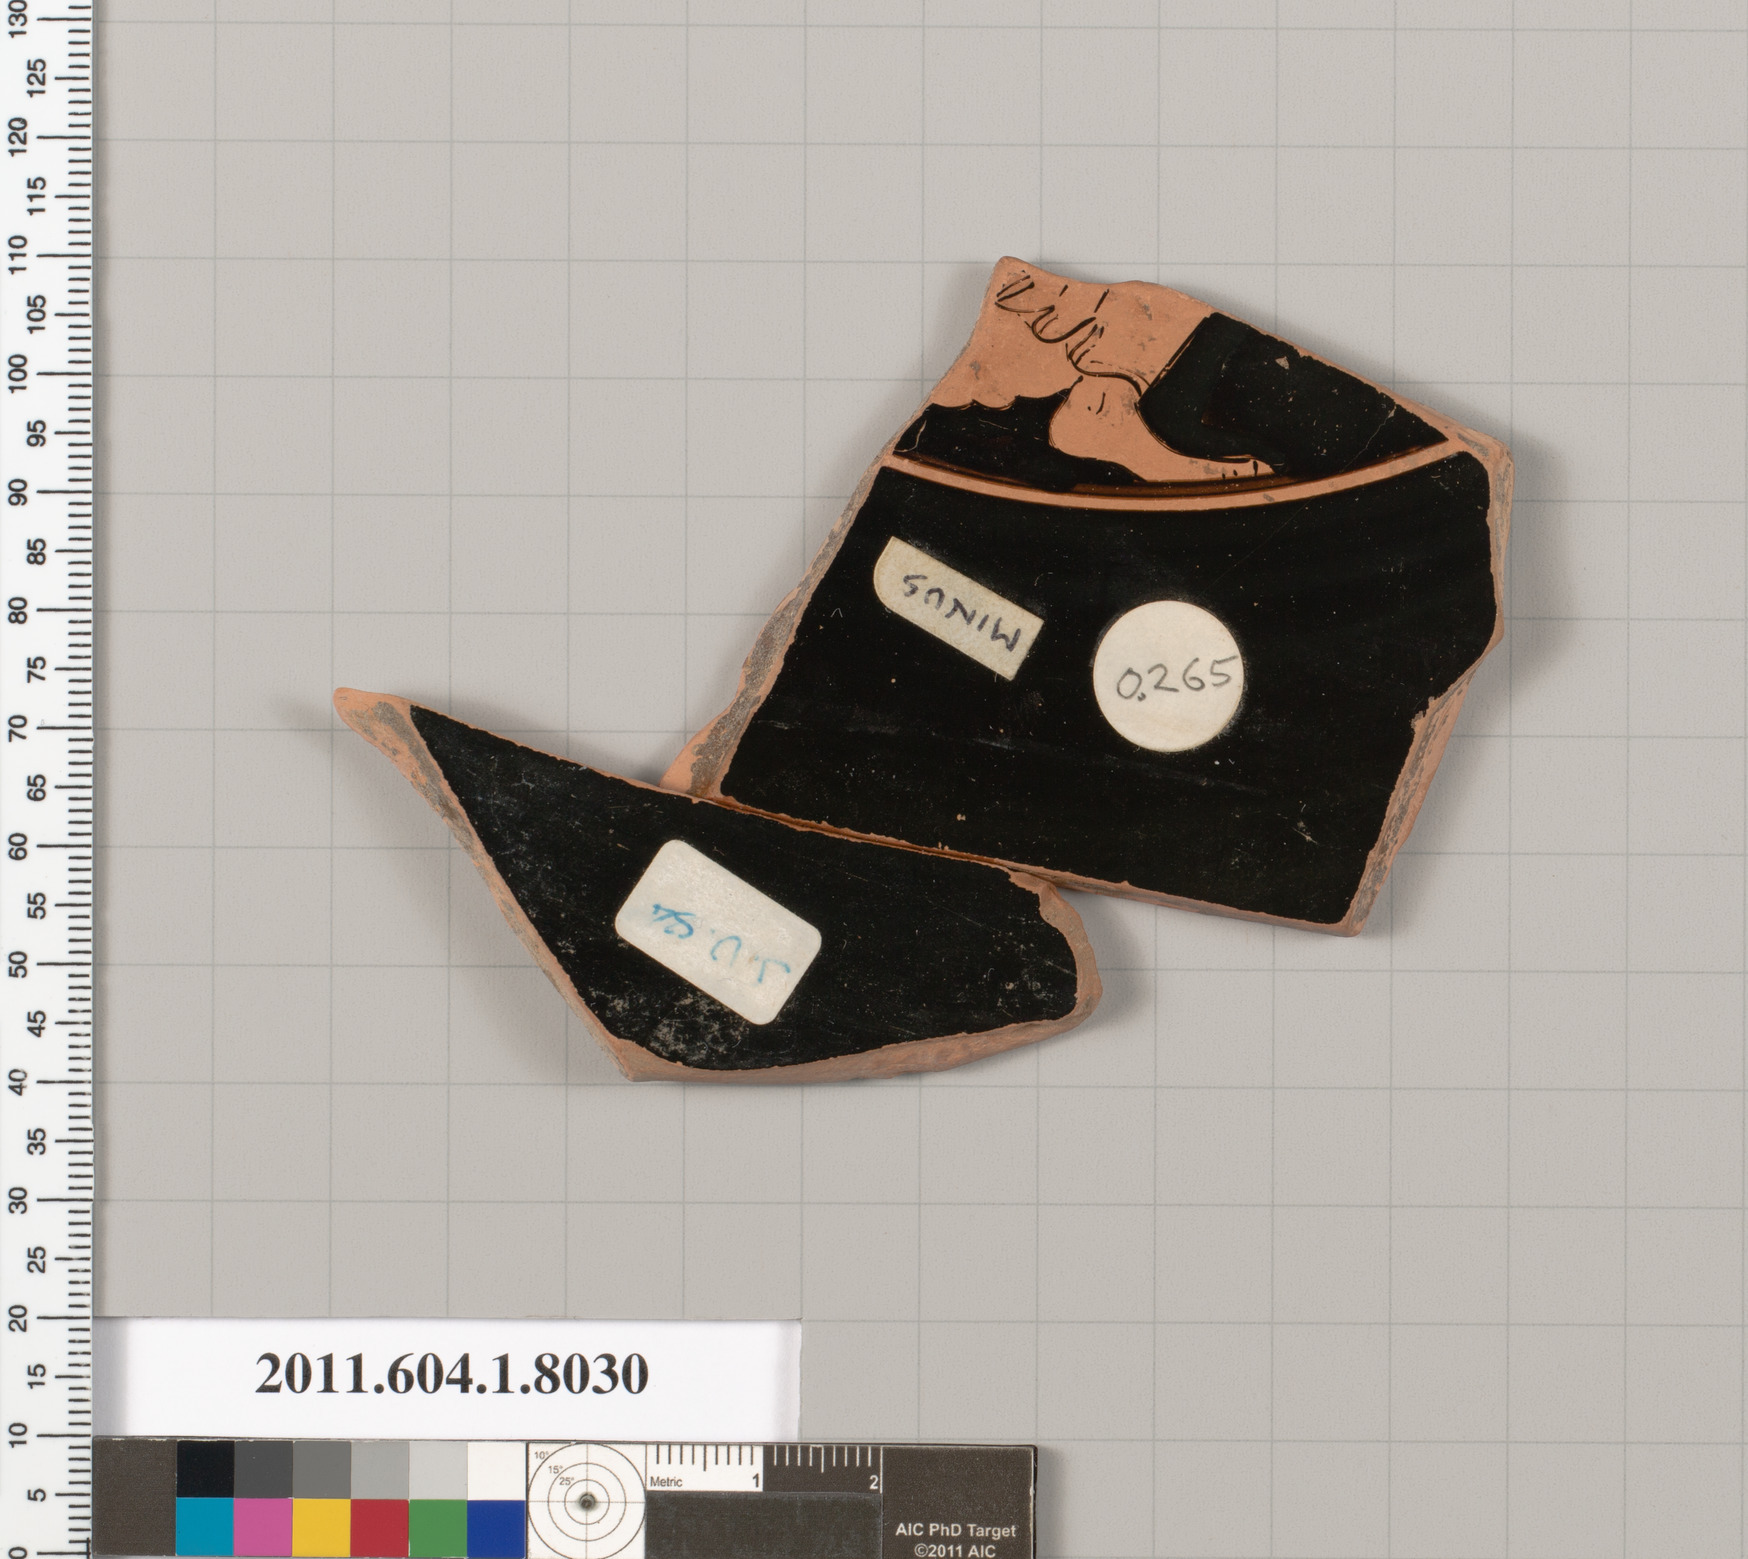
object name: kylix fragment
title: Terracotta fragment of a kylix (drinking cup)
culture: greek, attic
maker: poseidon painter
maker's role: artist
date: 510-500 BCE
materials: terracotta